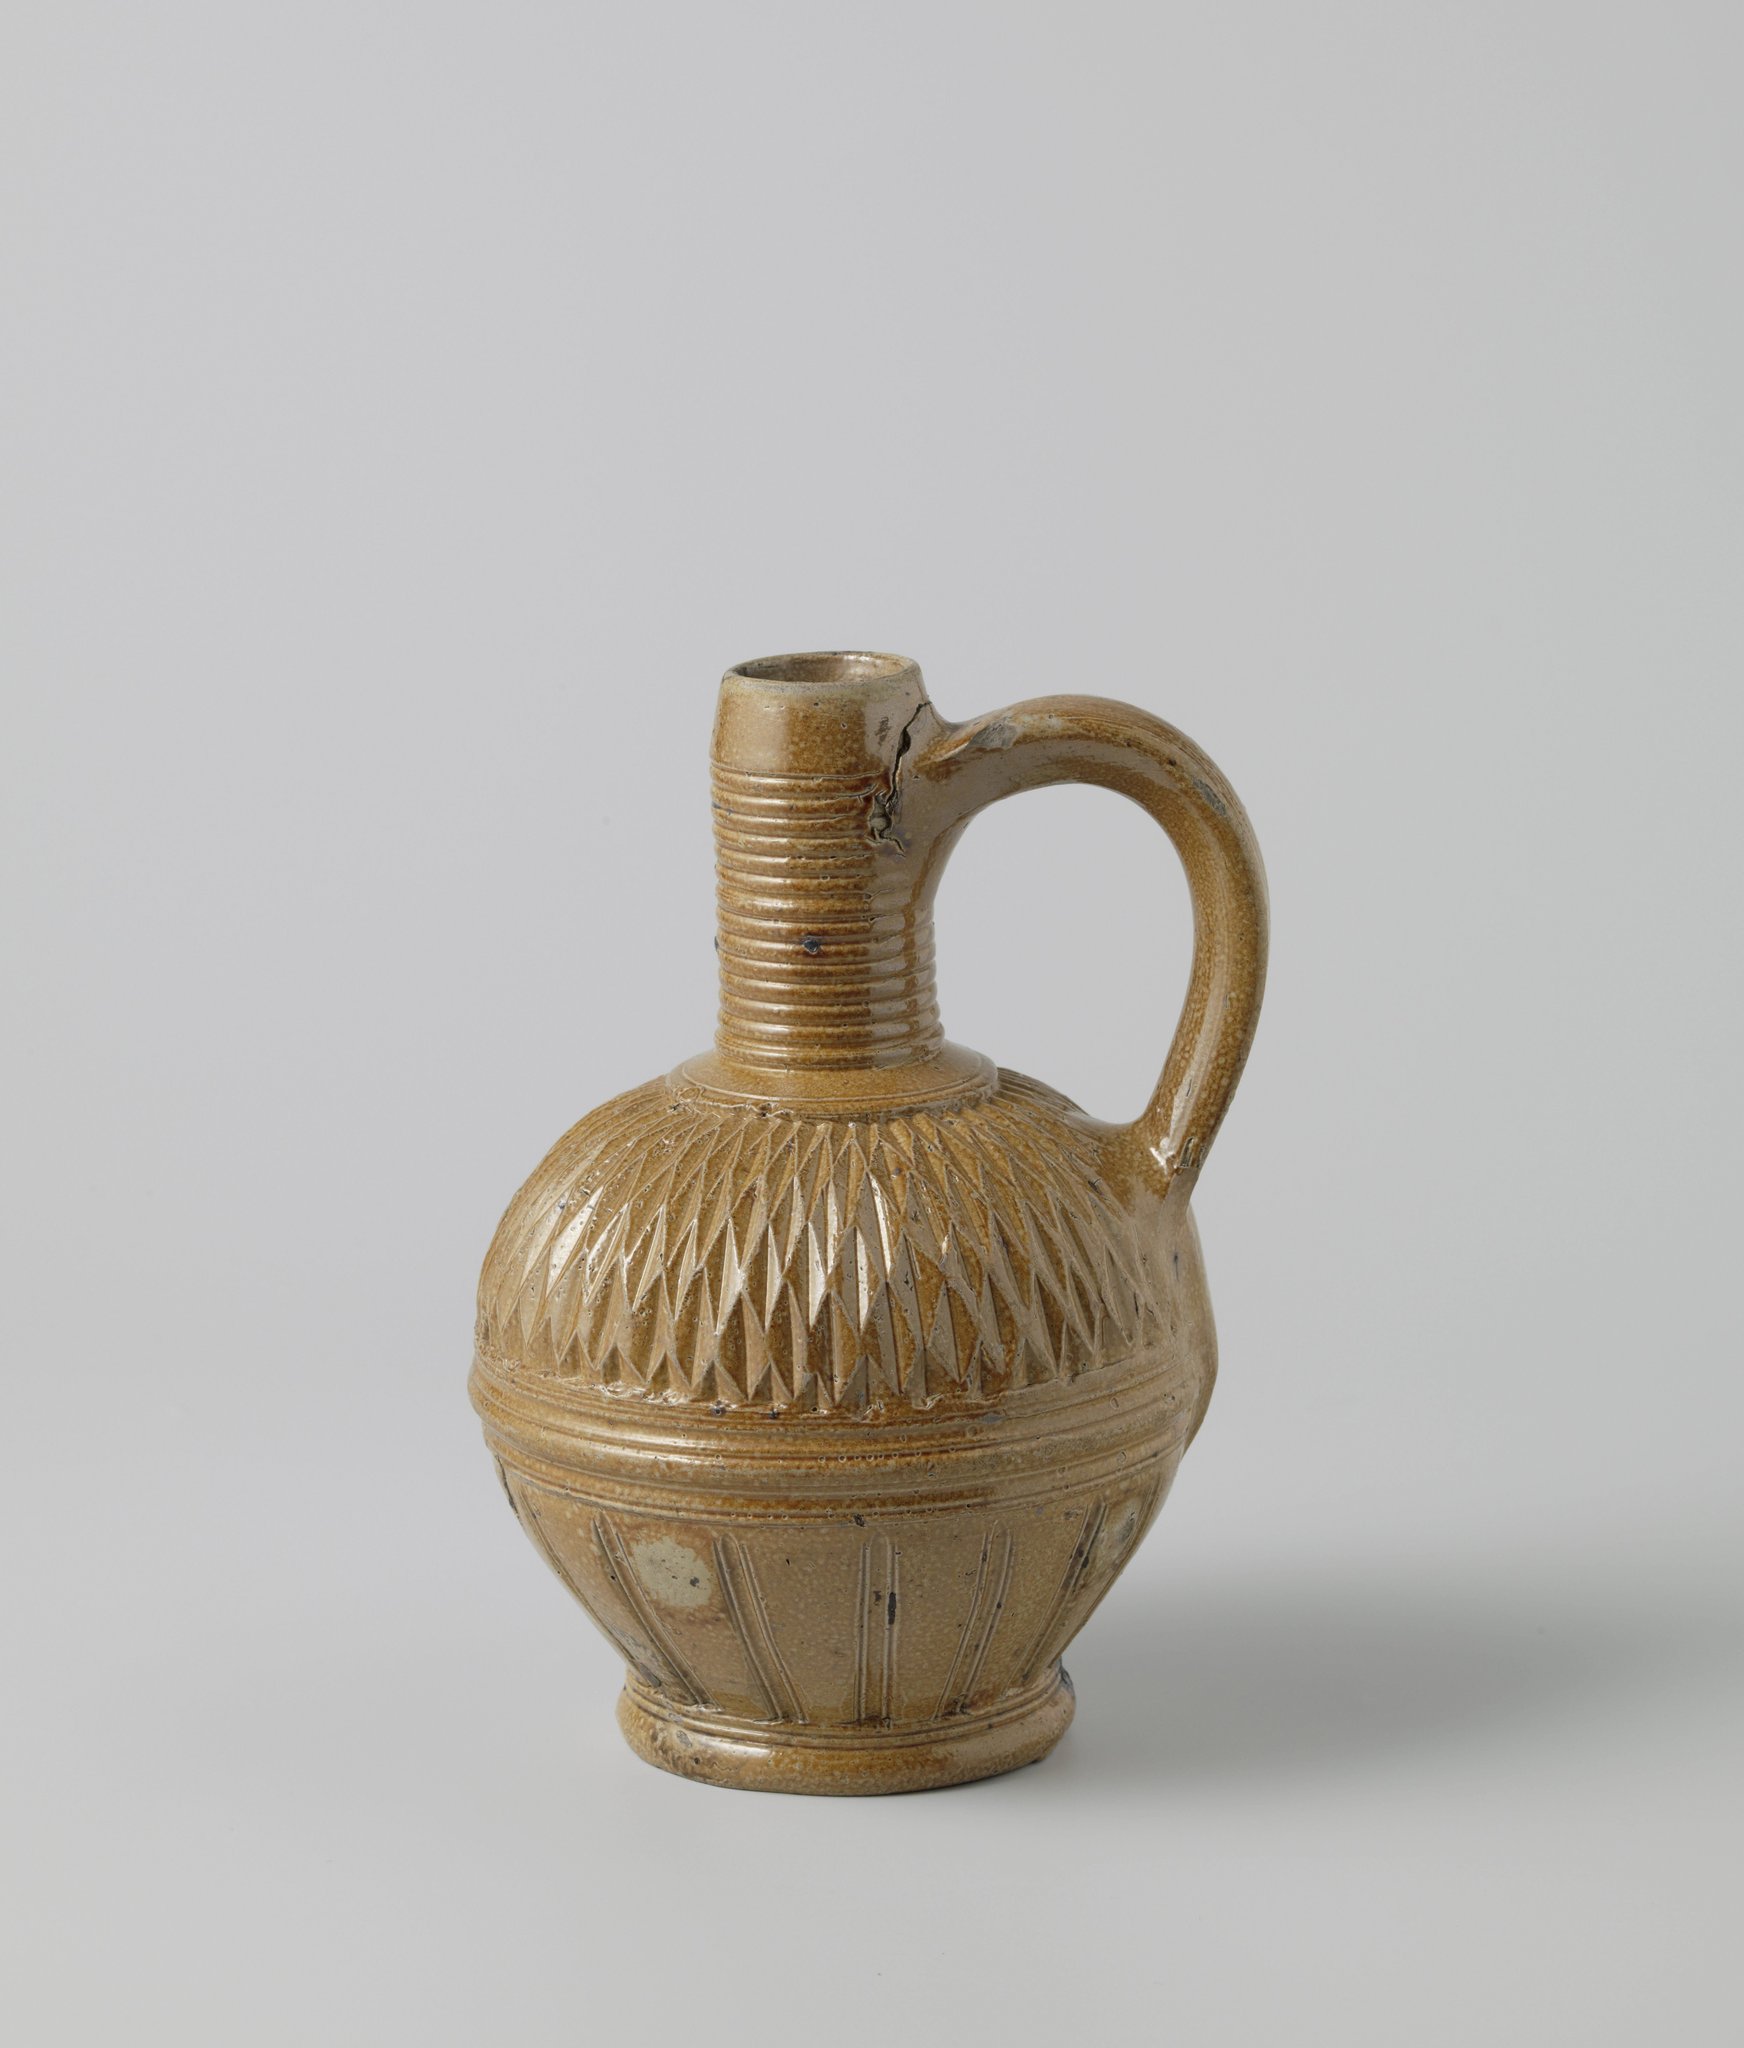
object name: jug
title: Jug with chip carving and ribbed neck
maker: Anonymous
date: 1590-1610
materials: engobe, glaze, stoneware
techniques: firing, forming, turning, vitrification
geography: raeren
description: Kruik van steengoed op standring met bolvormig lichaam en smalle, geribde nek. Het C-vormige oor is bevestigd aan de nek en de schouder. Bedekt met een bruine engobe. Het onderste deel van de buik is door ingegrifte lijnen verdeeld in vakken en met een profiel gescheiden van de met kerfsnede versierde schouder. Raeren.